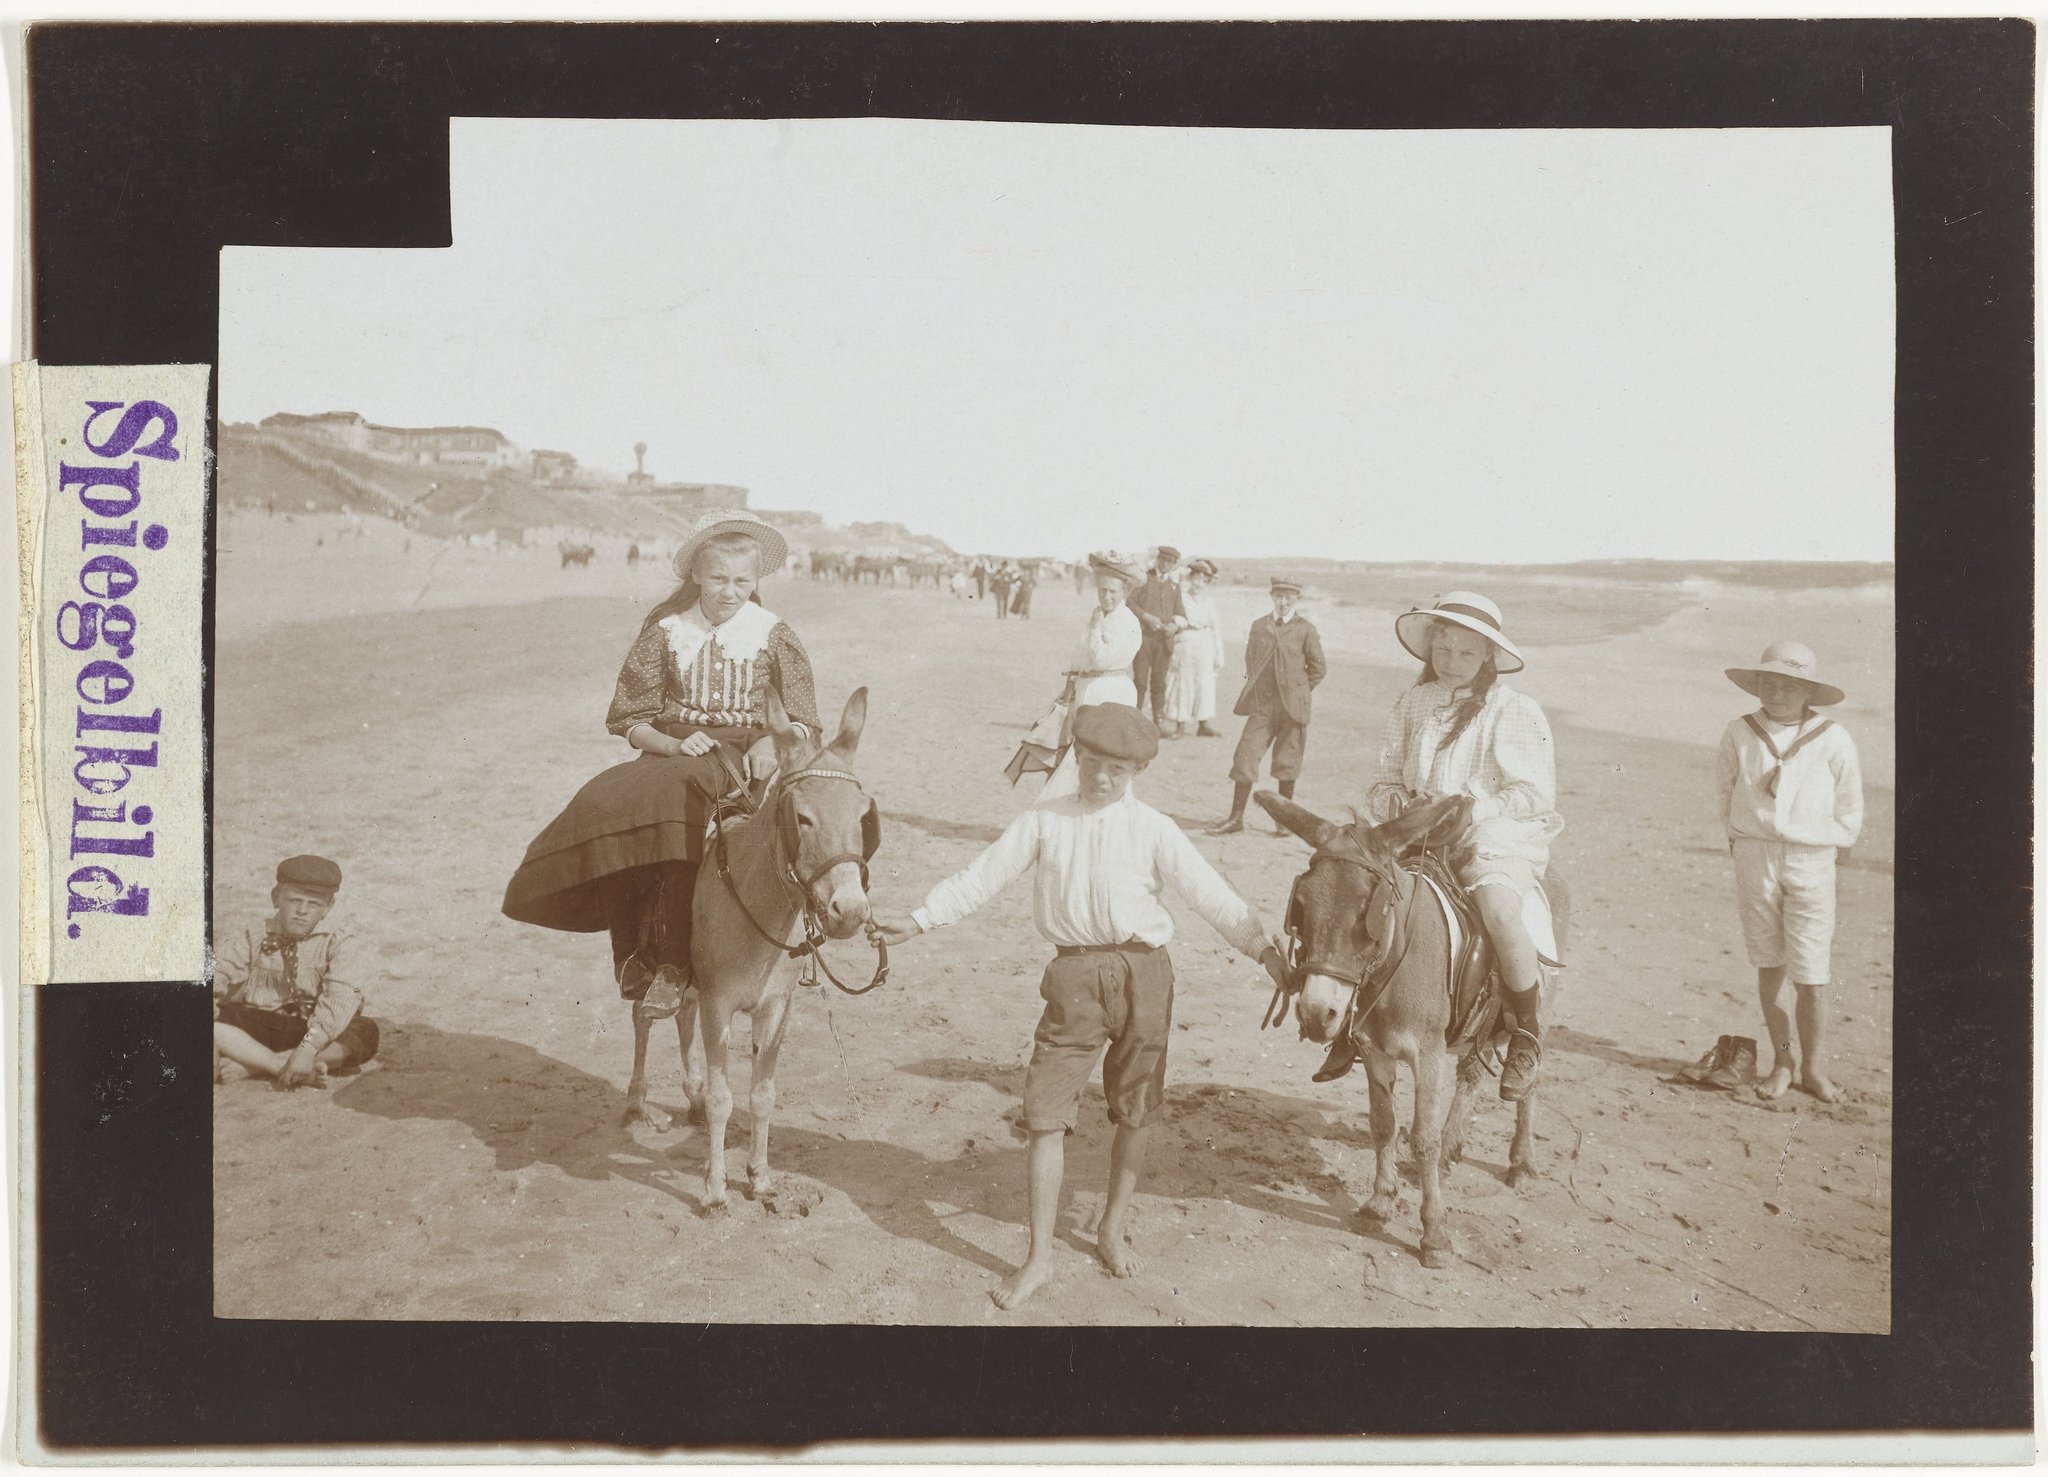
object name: photograph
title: Ezeltje rijden op het strand in Zandvoort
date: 1900-1905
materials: photographic support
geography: zandvoort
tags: beach (as place of recreation)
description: Twee kinderen rijden op ezeltjes langs het strand. Een jongetje houdt de ezeltjes vast. Anderen kijken toe. M.o. opschrift 'Spiegelbild'.